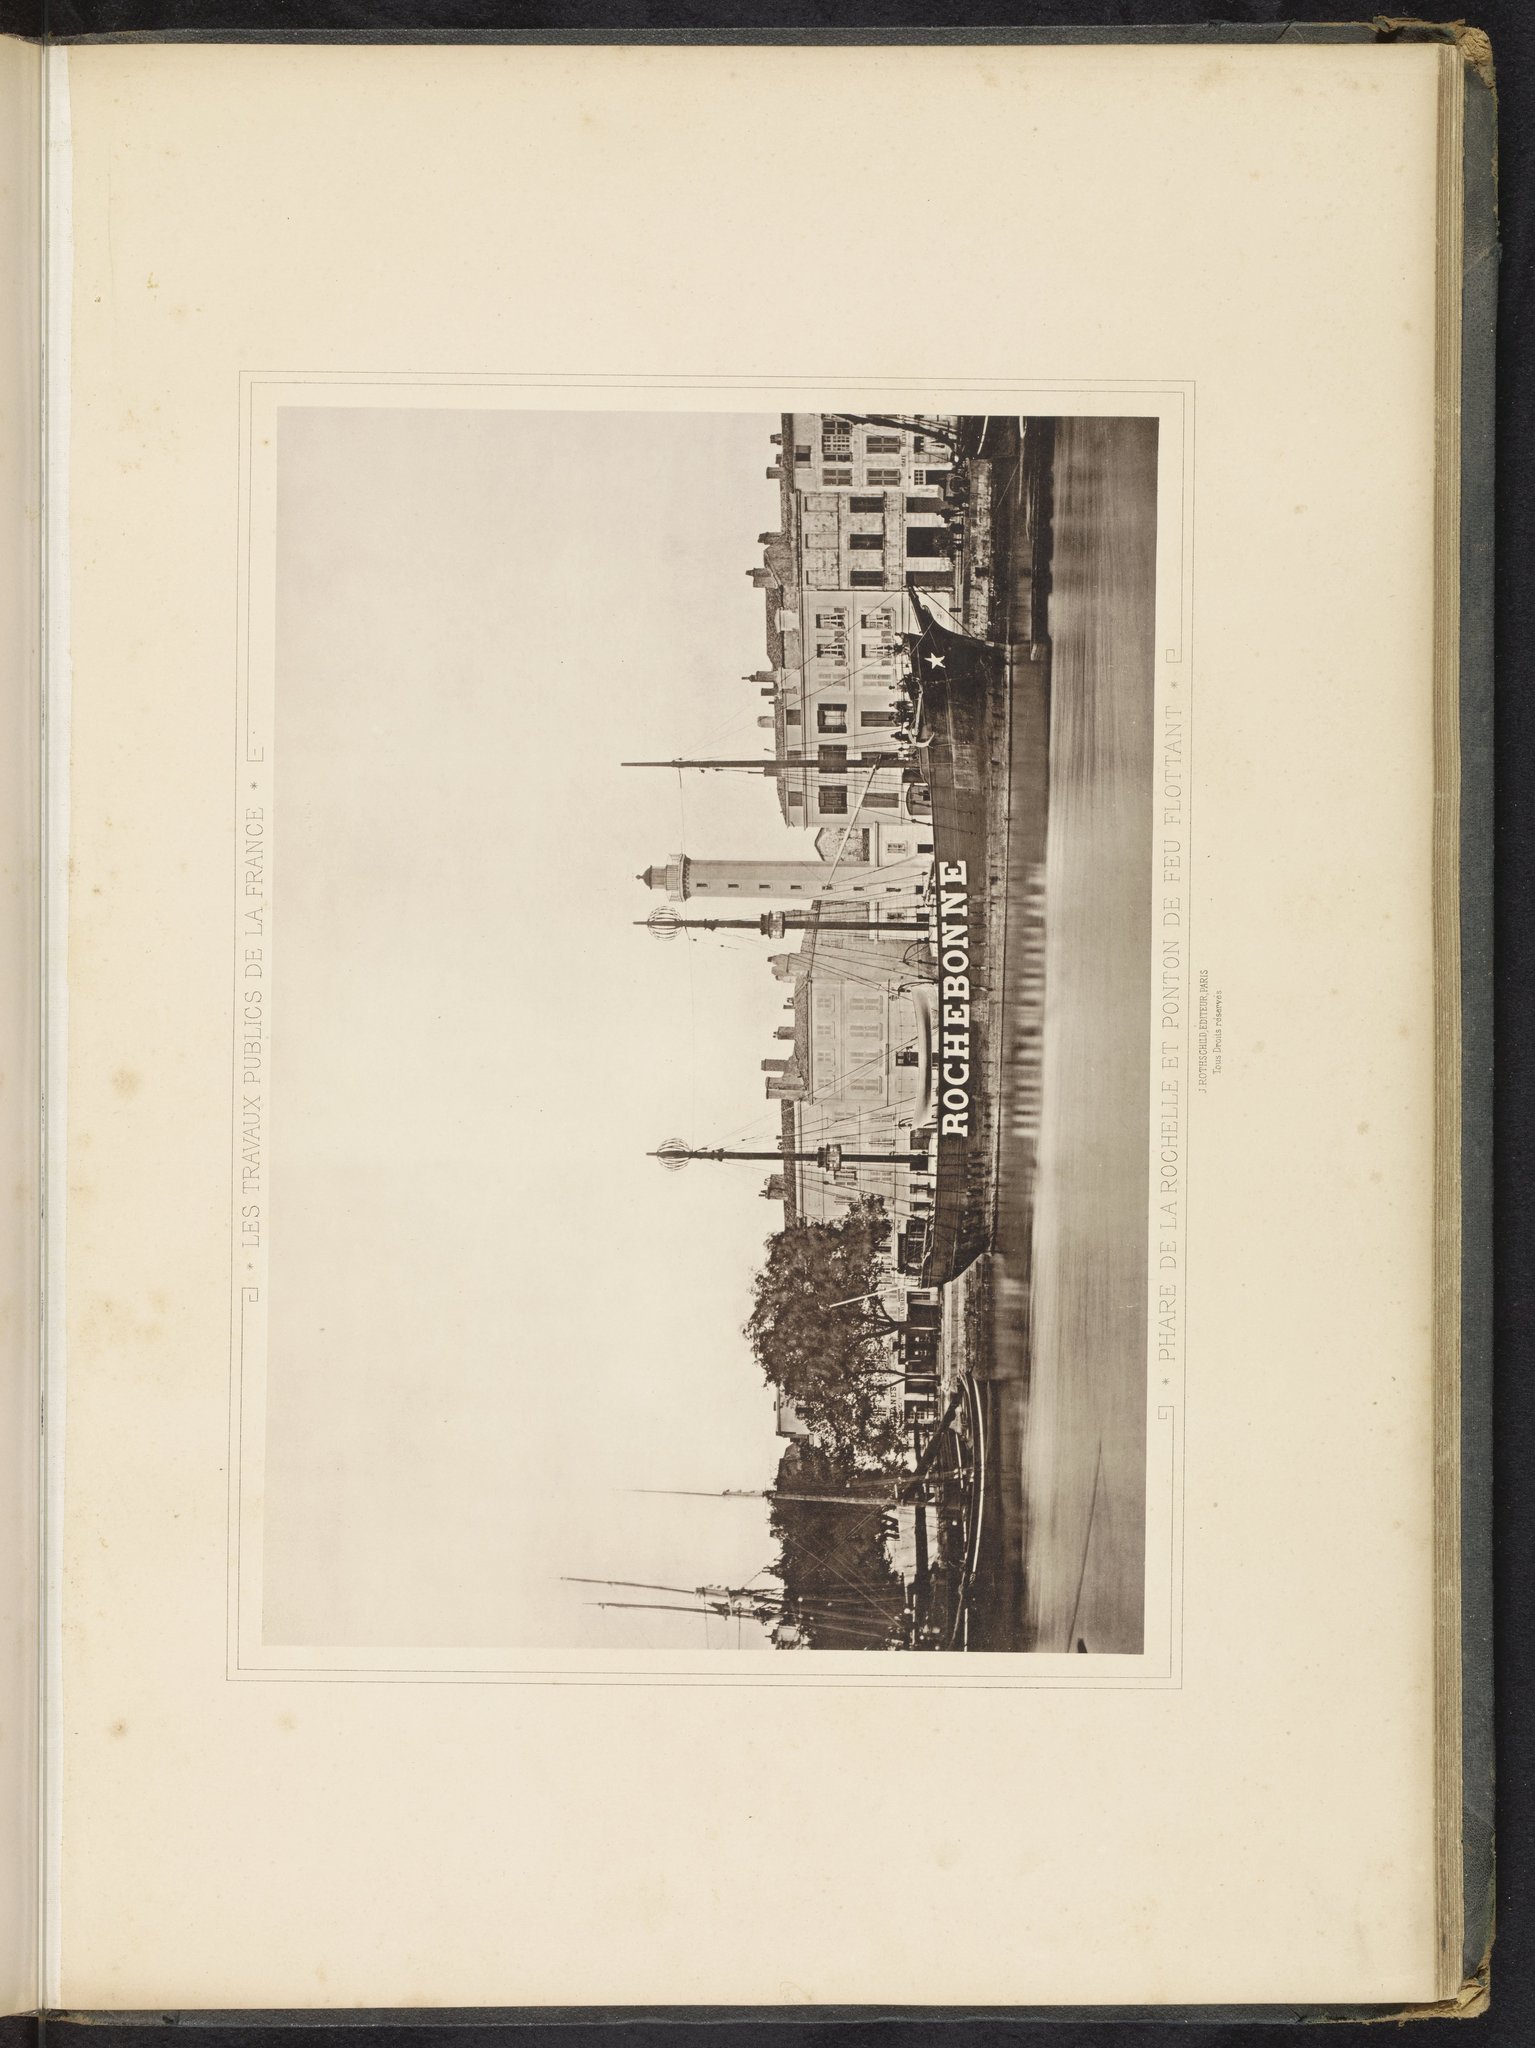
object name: photomechanical print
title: Phare de La Rochelle et ponton de feu flottant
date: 1873-1883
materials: paper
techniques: photograph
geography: france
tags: harbour, lighthouse, lightship